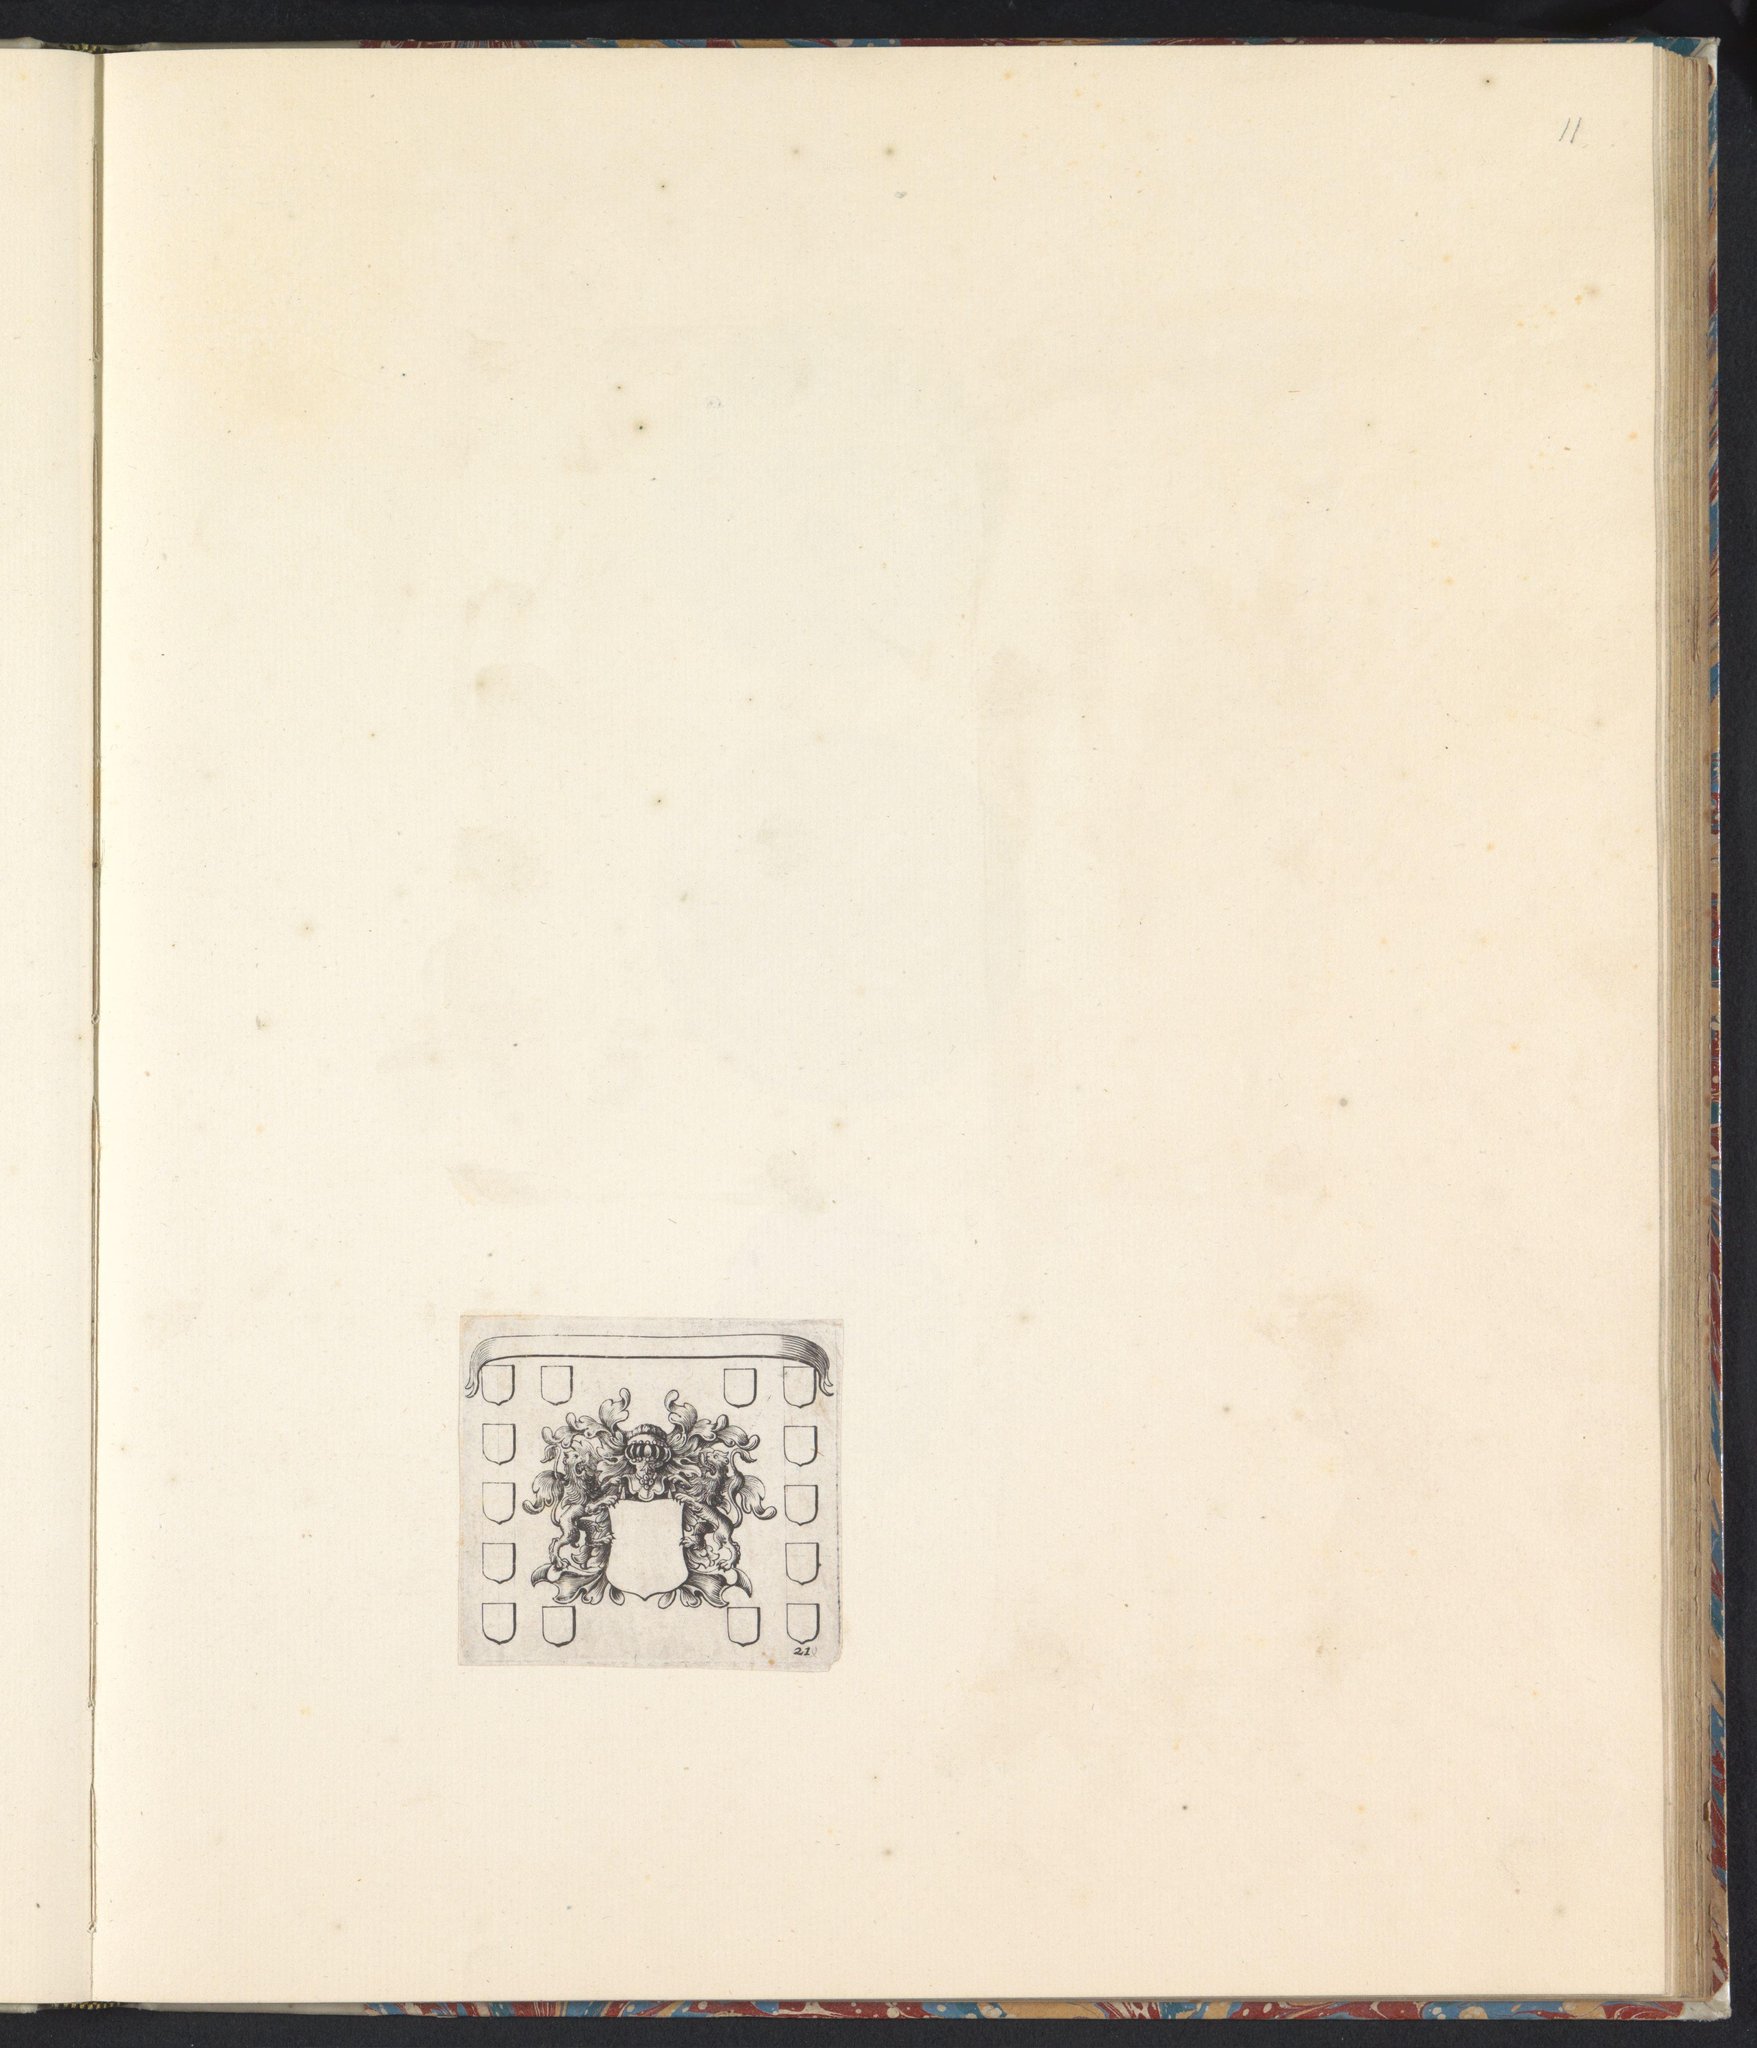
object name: album leaf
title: Wapen met blanco schilden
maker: Anonymous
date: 1550-1650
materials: paper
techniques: engraving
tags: armorial bearing, heraldry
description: Een wapen met blanco schild, geflankeerd door twee klimmende leeuwen. Daaromheen een lege banderol en veertien lege schilden. De prent maakt deel uit van een album.